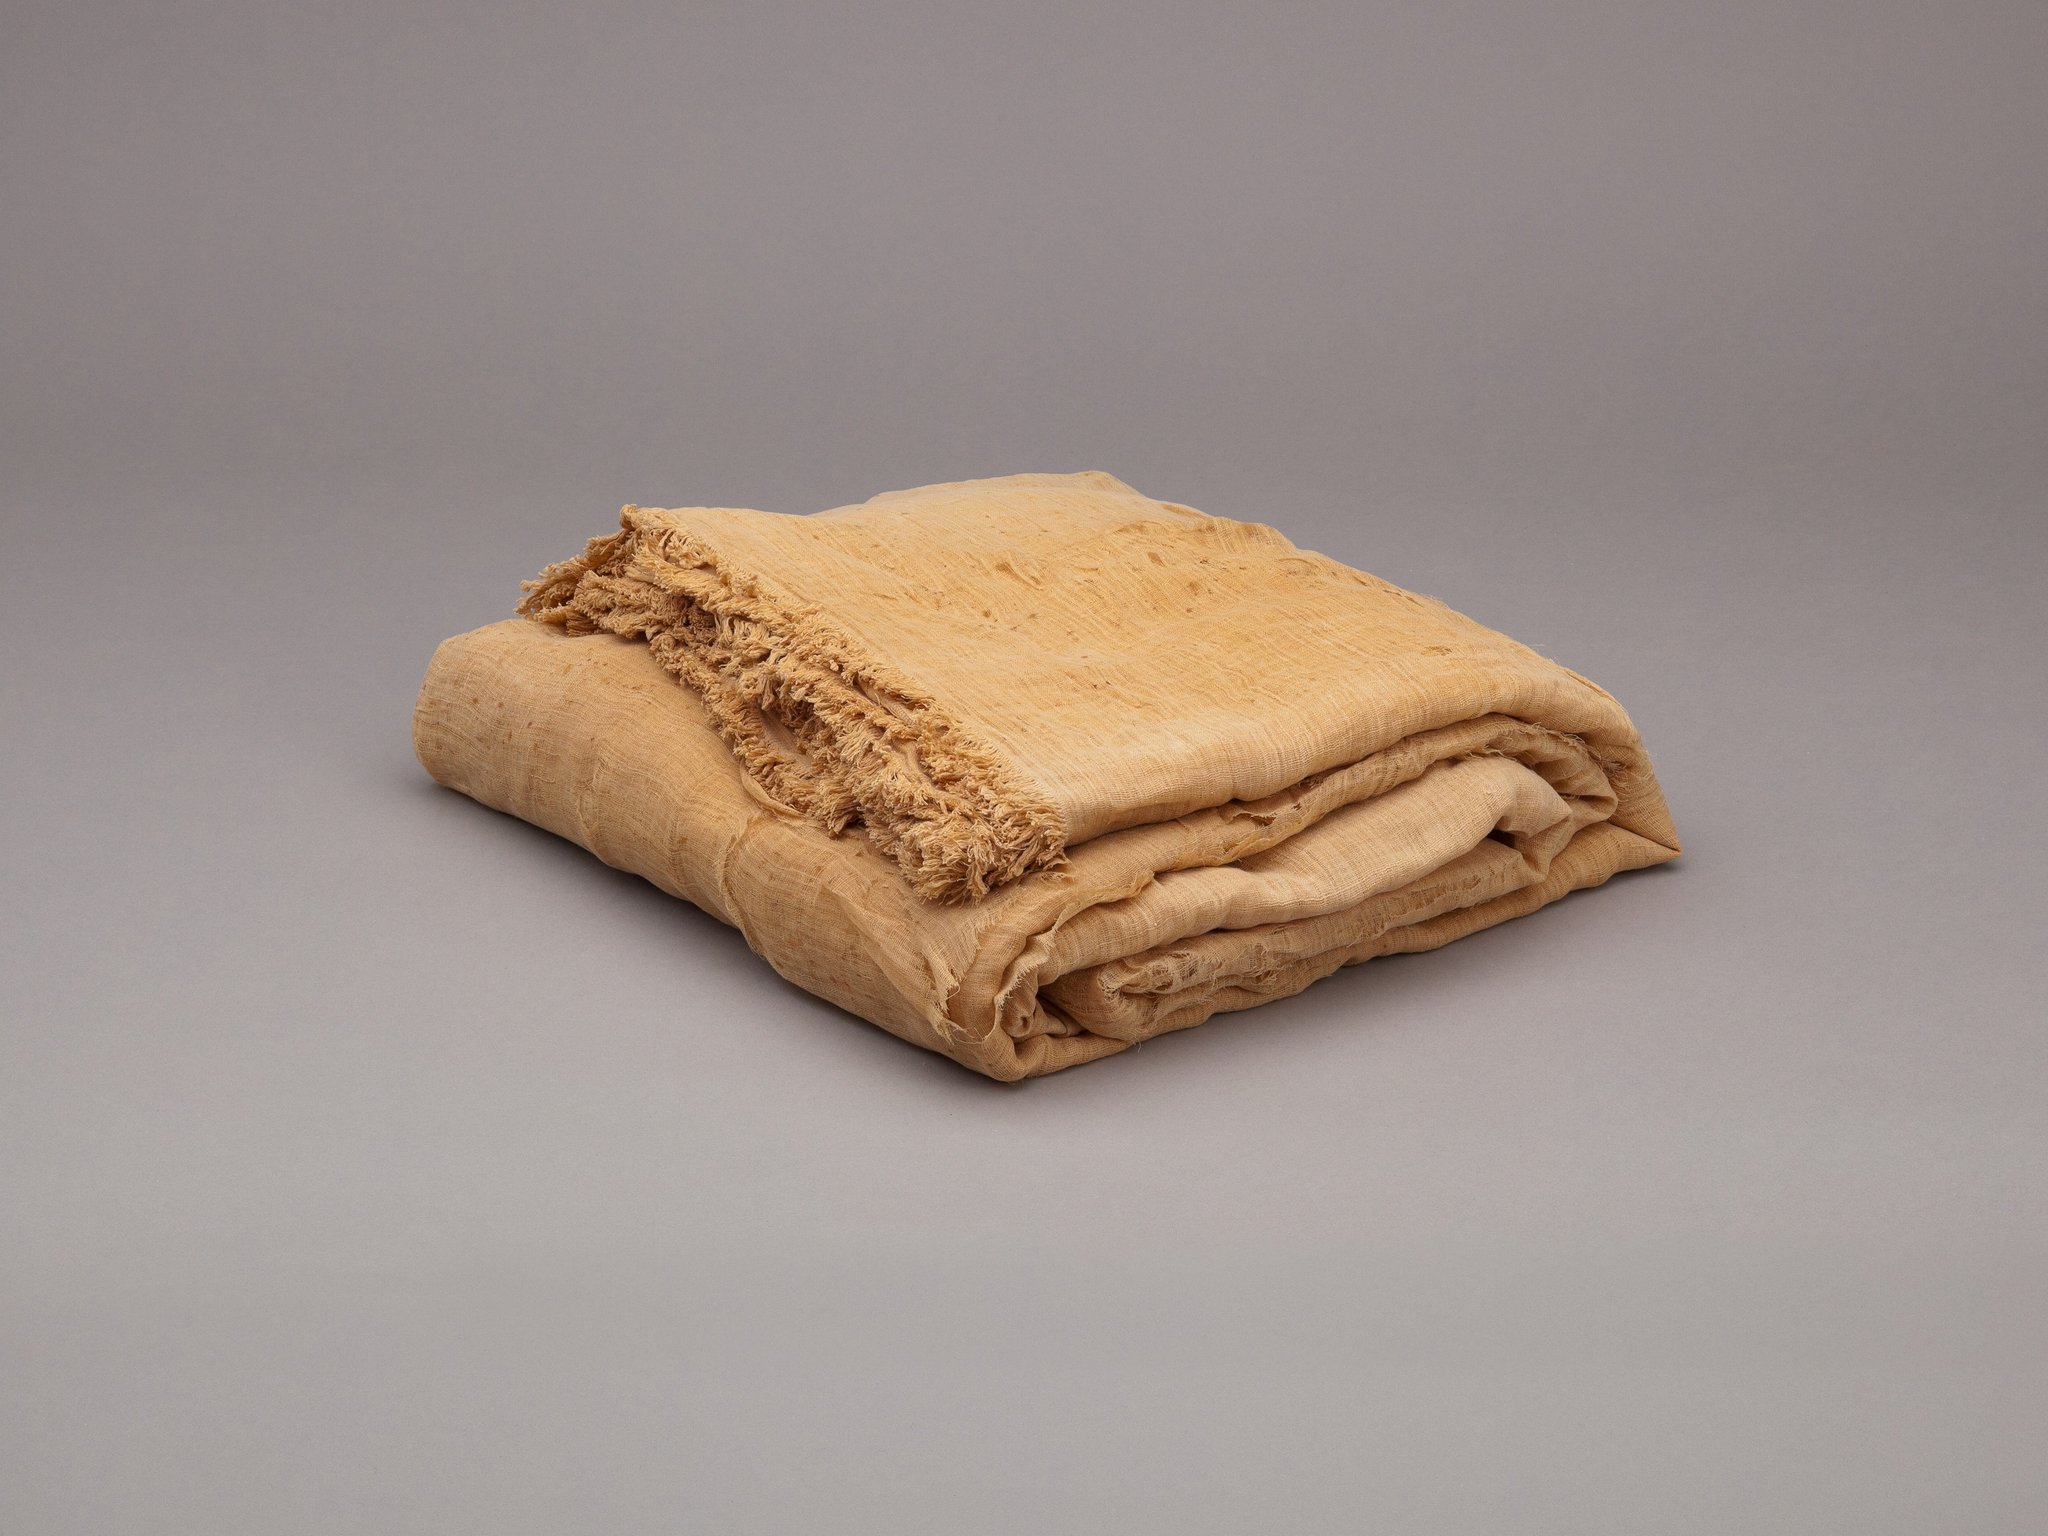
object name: sheet, inscribed, linen mark, medium spin, irregular weave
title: Sheet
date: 1492-1473 BCE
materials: ink, linen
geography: egypt